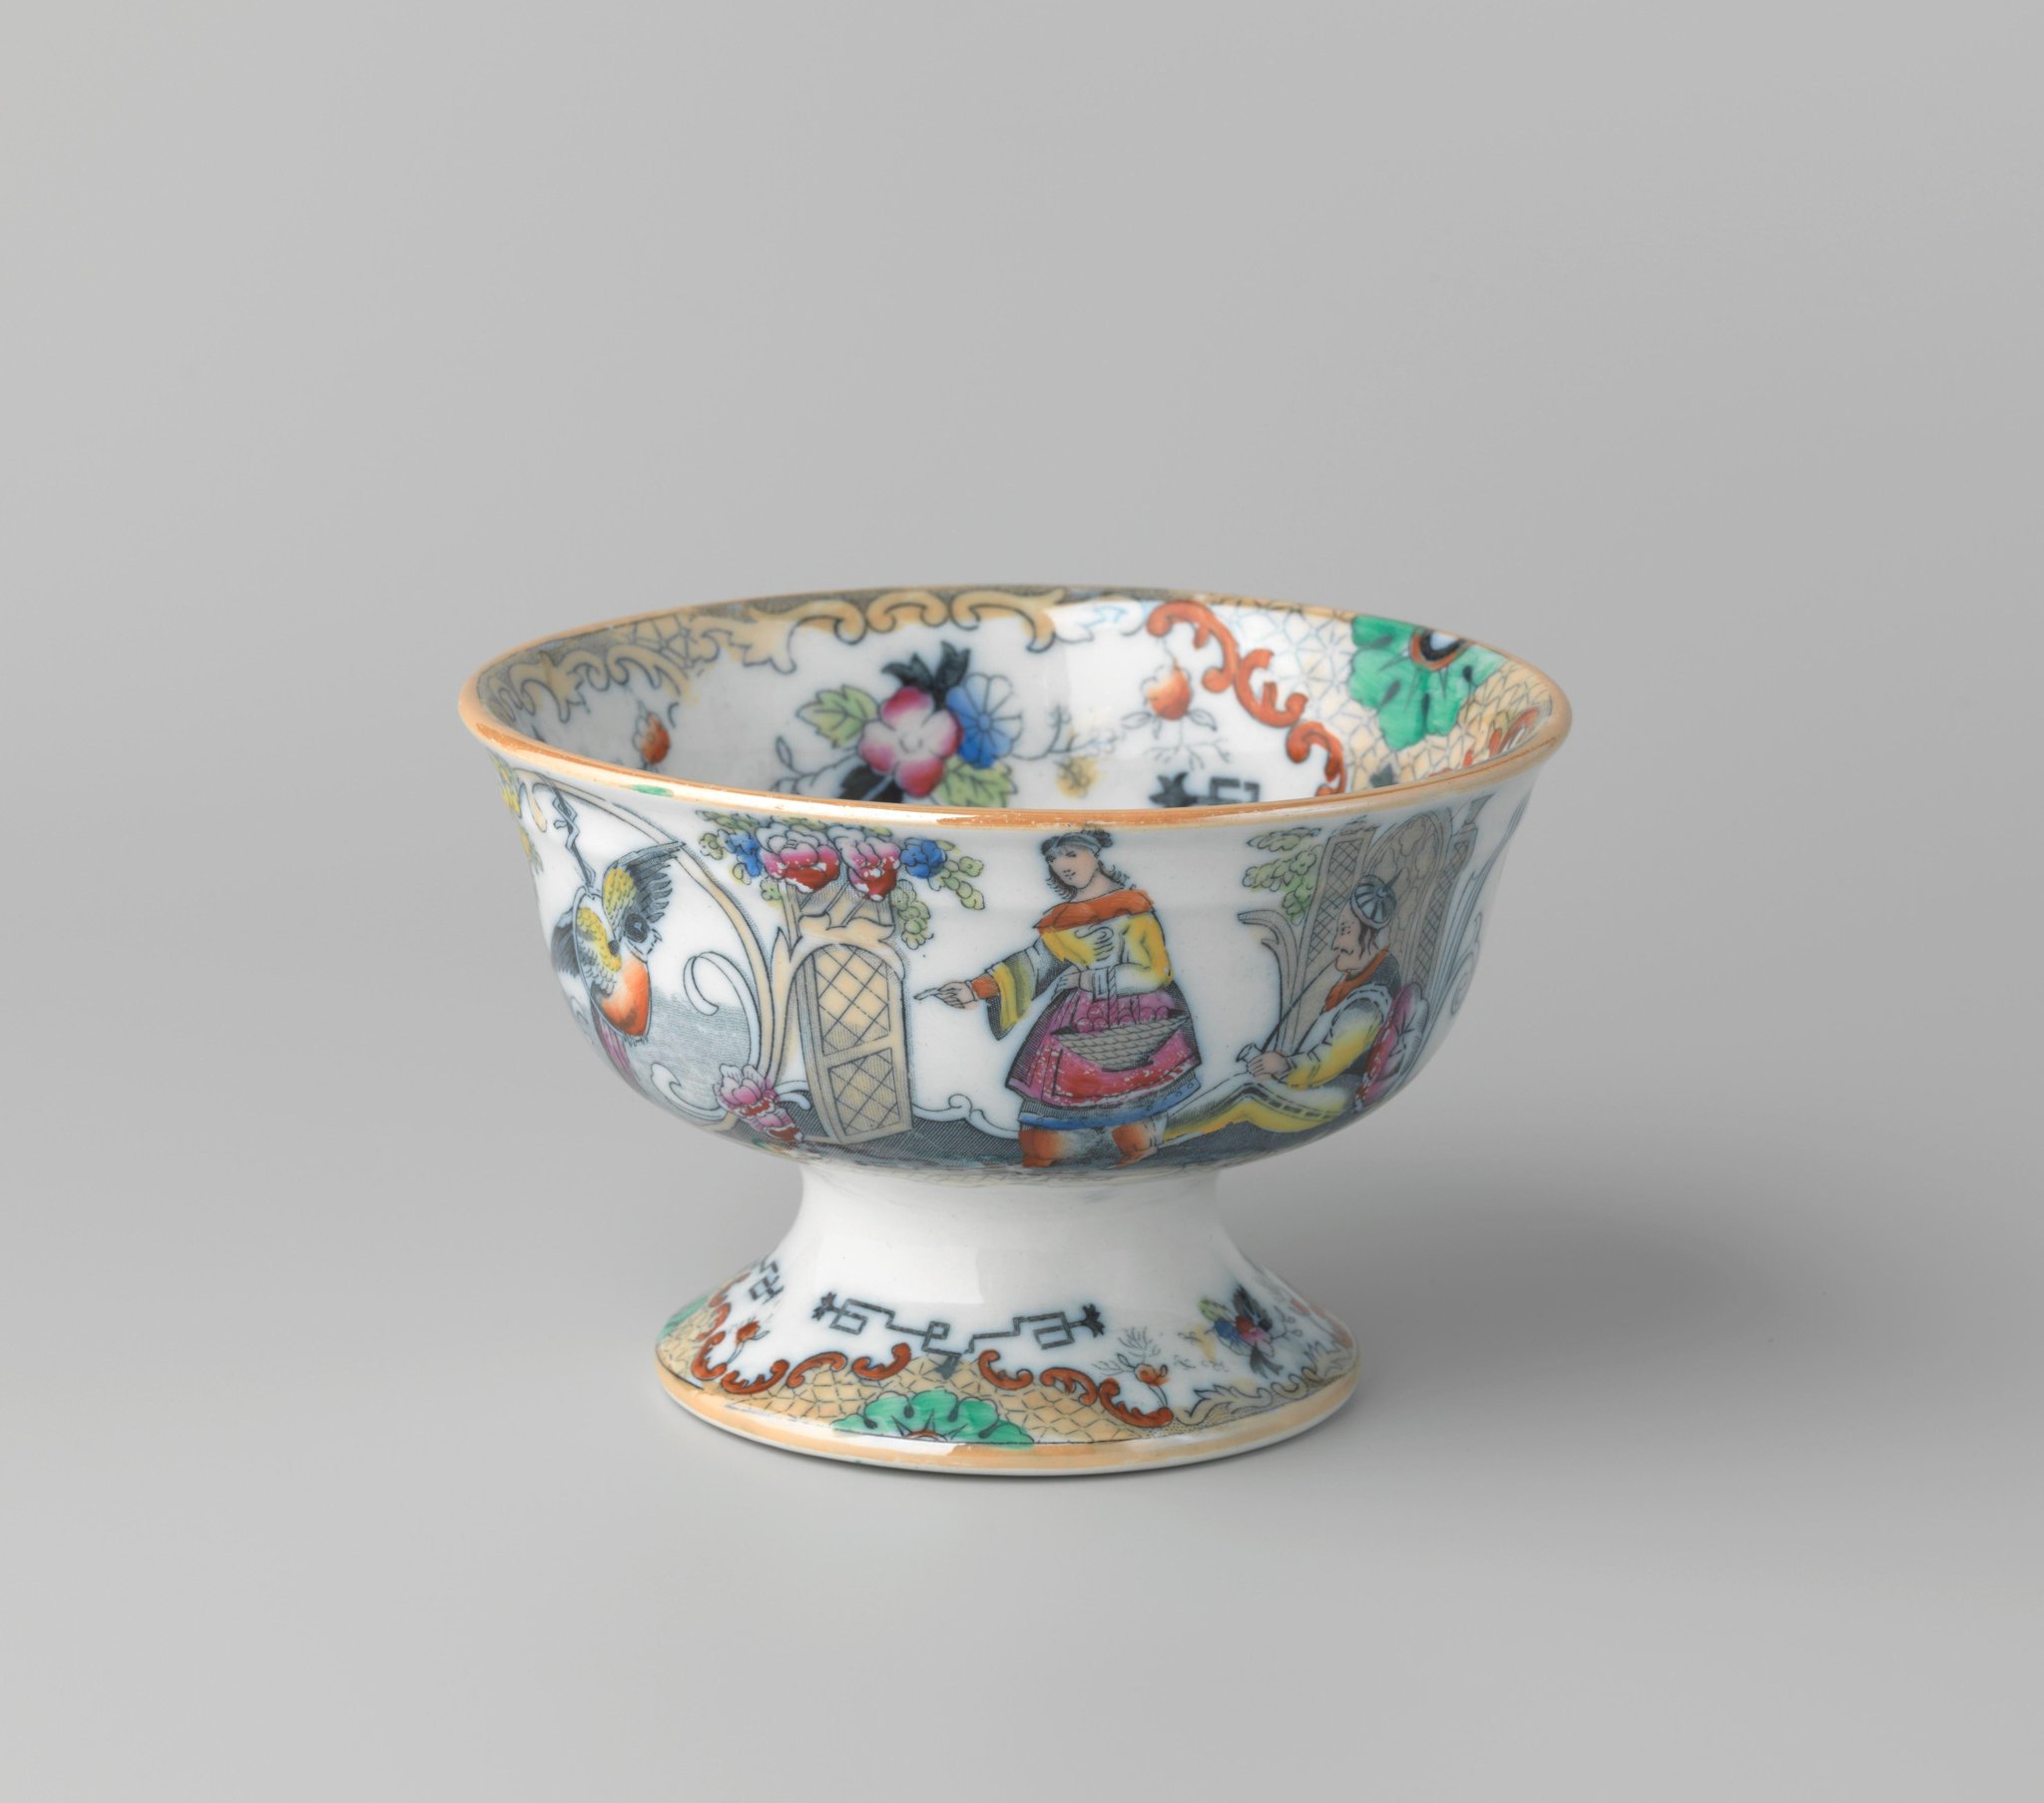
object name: bowl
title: Kastkom met papegaai op een stok, een vrouw en een pijprokende man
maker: petrus regout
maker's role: plateelbakker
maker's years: 1801-1879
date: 1883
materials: earthenware, glaze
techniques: vitrification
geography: maastricht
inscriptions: mark: ‘P. REGOUT // Ao 1836 // MAASTRICHT // PACHA’, check stamp: ‘E 2’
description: Kastkom van aardewerk met blauwzwart transferdecor, met moffelkleuren en okerluster. De wand is aan de buitenzijde gedecoreerd met voorstellingen van een papegaai op een stok, een vrouw met een mand bloemen en een pijprokende man. De binnenzijde van de wand en de voetrand zijn gedecoreerd met bloemen, voluten en abstracte motieven.